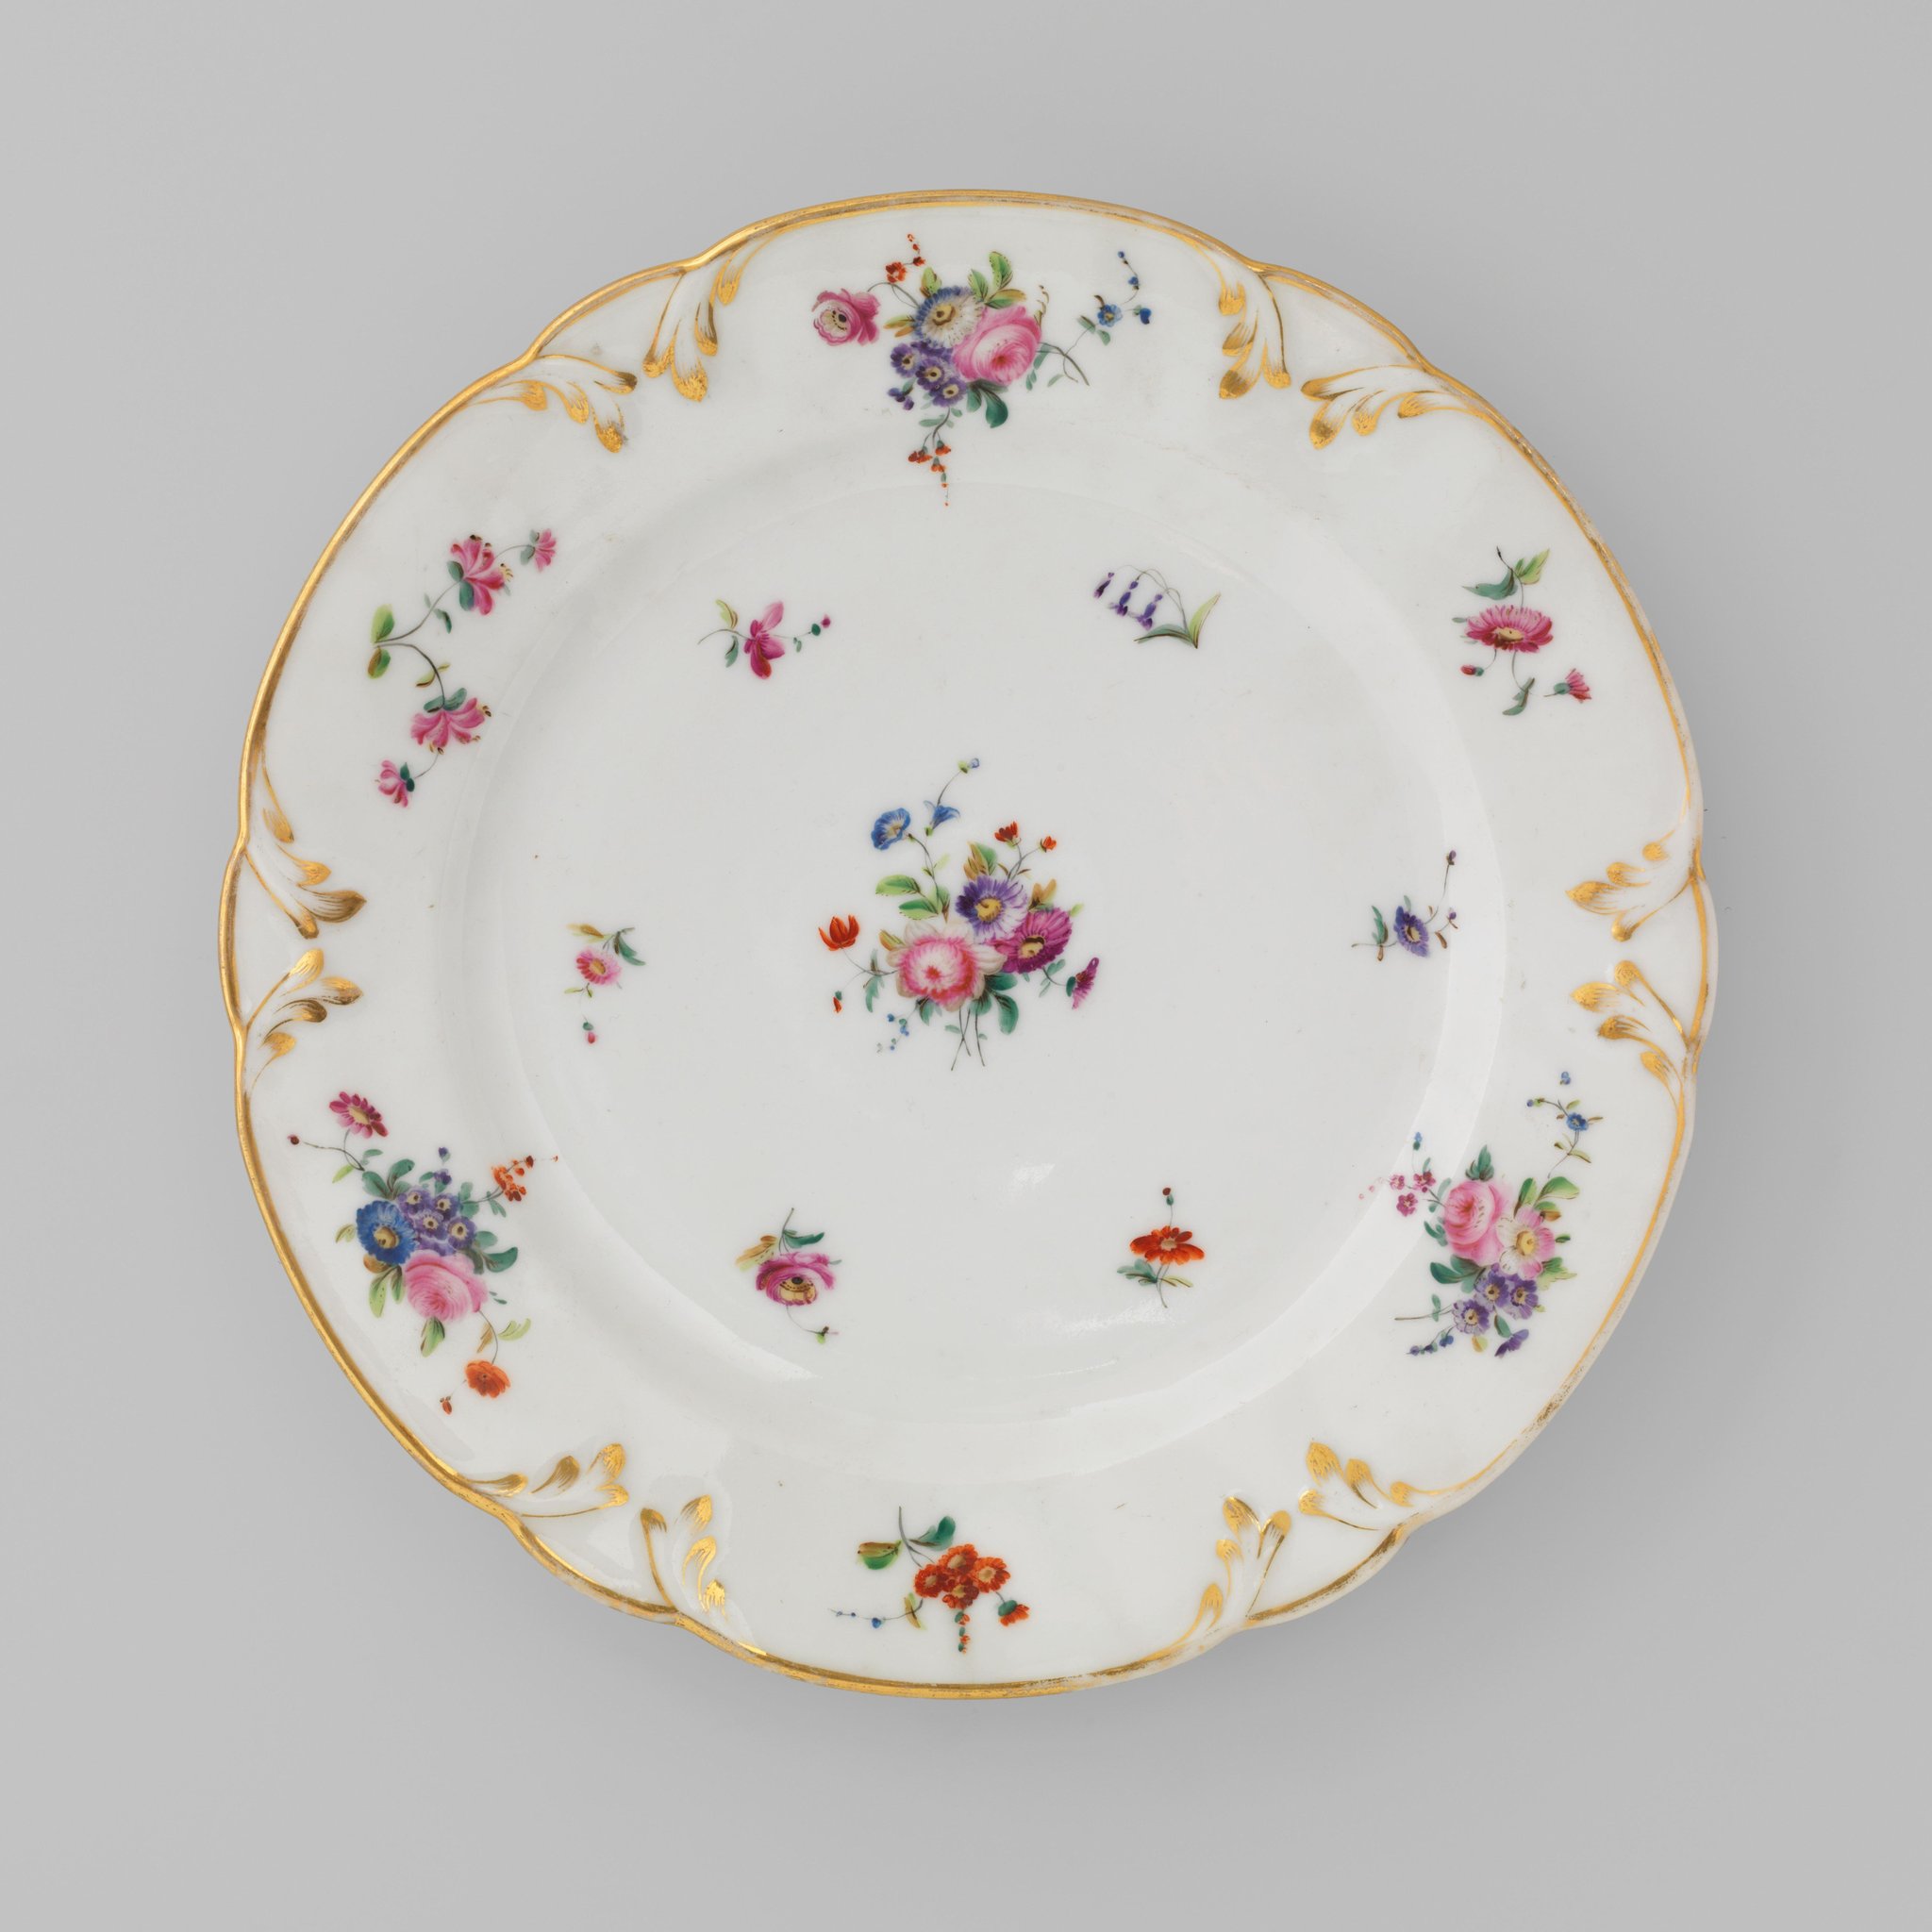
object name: service set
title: Plate with bouquets and flower sprays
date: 1839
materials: glaze, gold, paint, porcelain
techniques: firing, forming, gilding, turning, vitrification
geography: paris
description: Bord van porselein met een gelobde rand, beschilderd op het glazuur in blauw, rood, roze, groen, geel, paars, zwart en goud. Op het plat boeketten van verschillende bloemen en strooibloemen. Vanuit de gelobde, gouden rand, gemodelleerde bladranken in reliëf, aangezet met goud. Hiertussen boeketten. Drie proenen op de onderzijde.